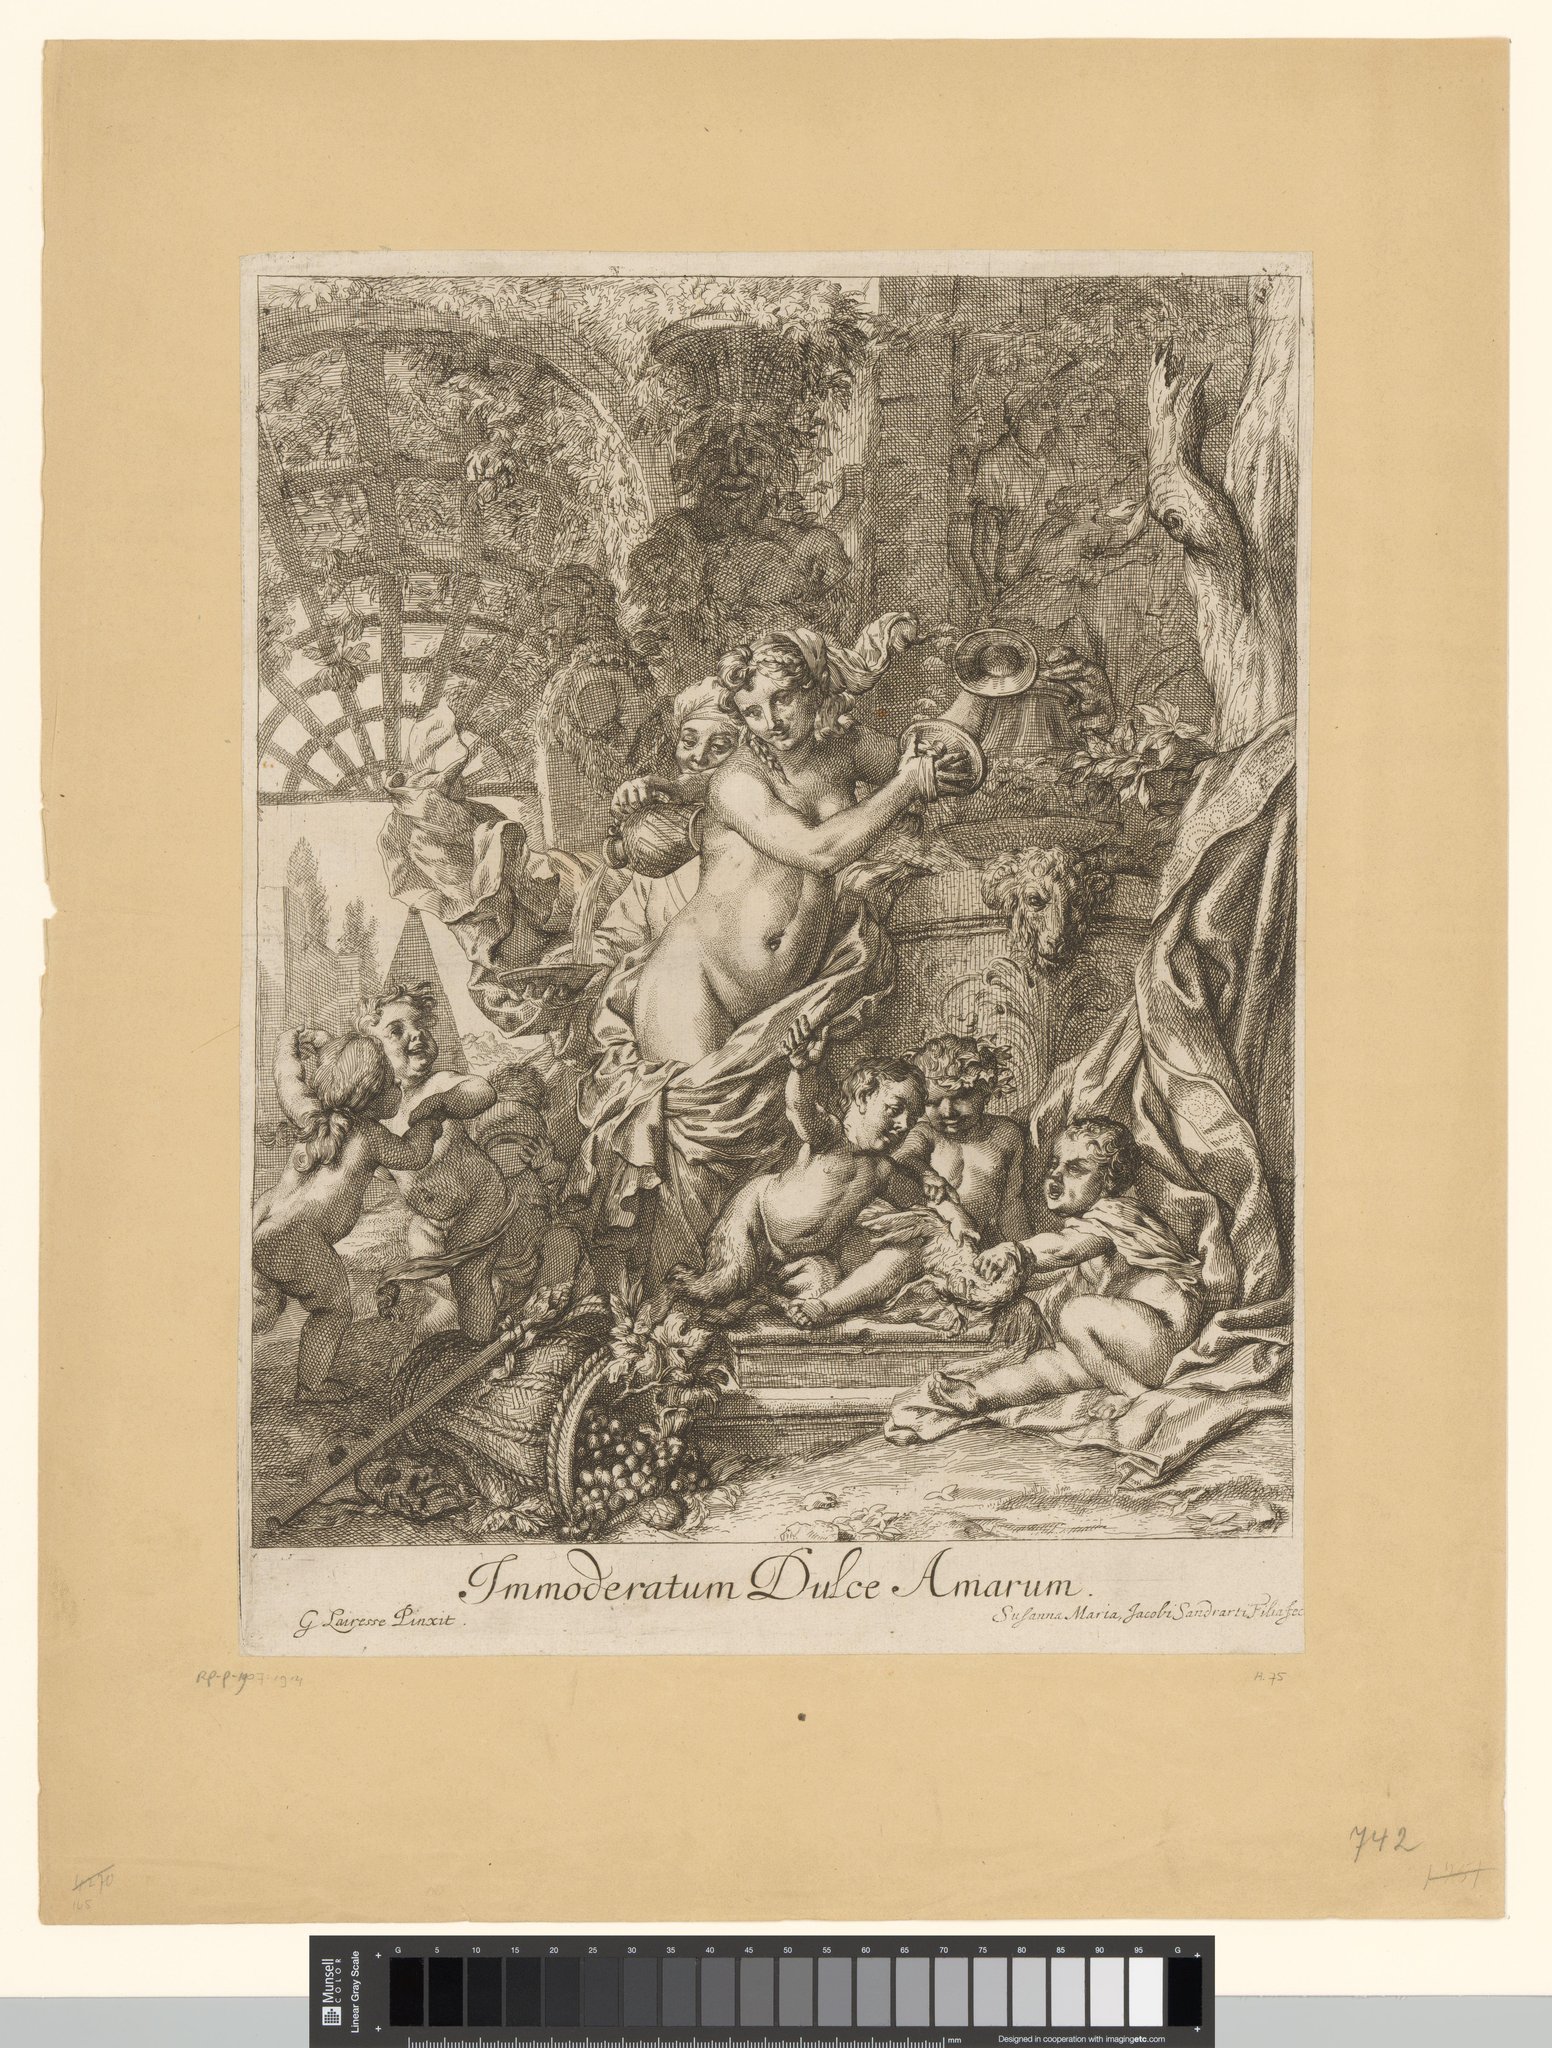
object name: print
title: Bachanaal met kinderen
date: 1668-1716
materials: paper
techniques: etching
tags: children's bacchanal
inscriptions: collector's mark: Lugt 2228